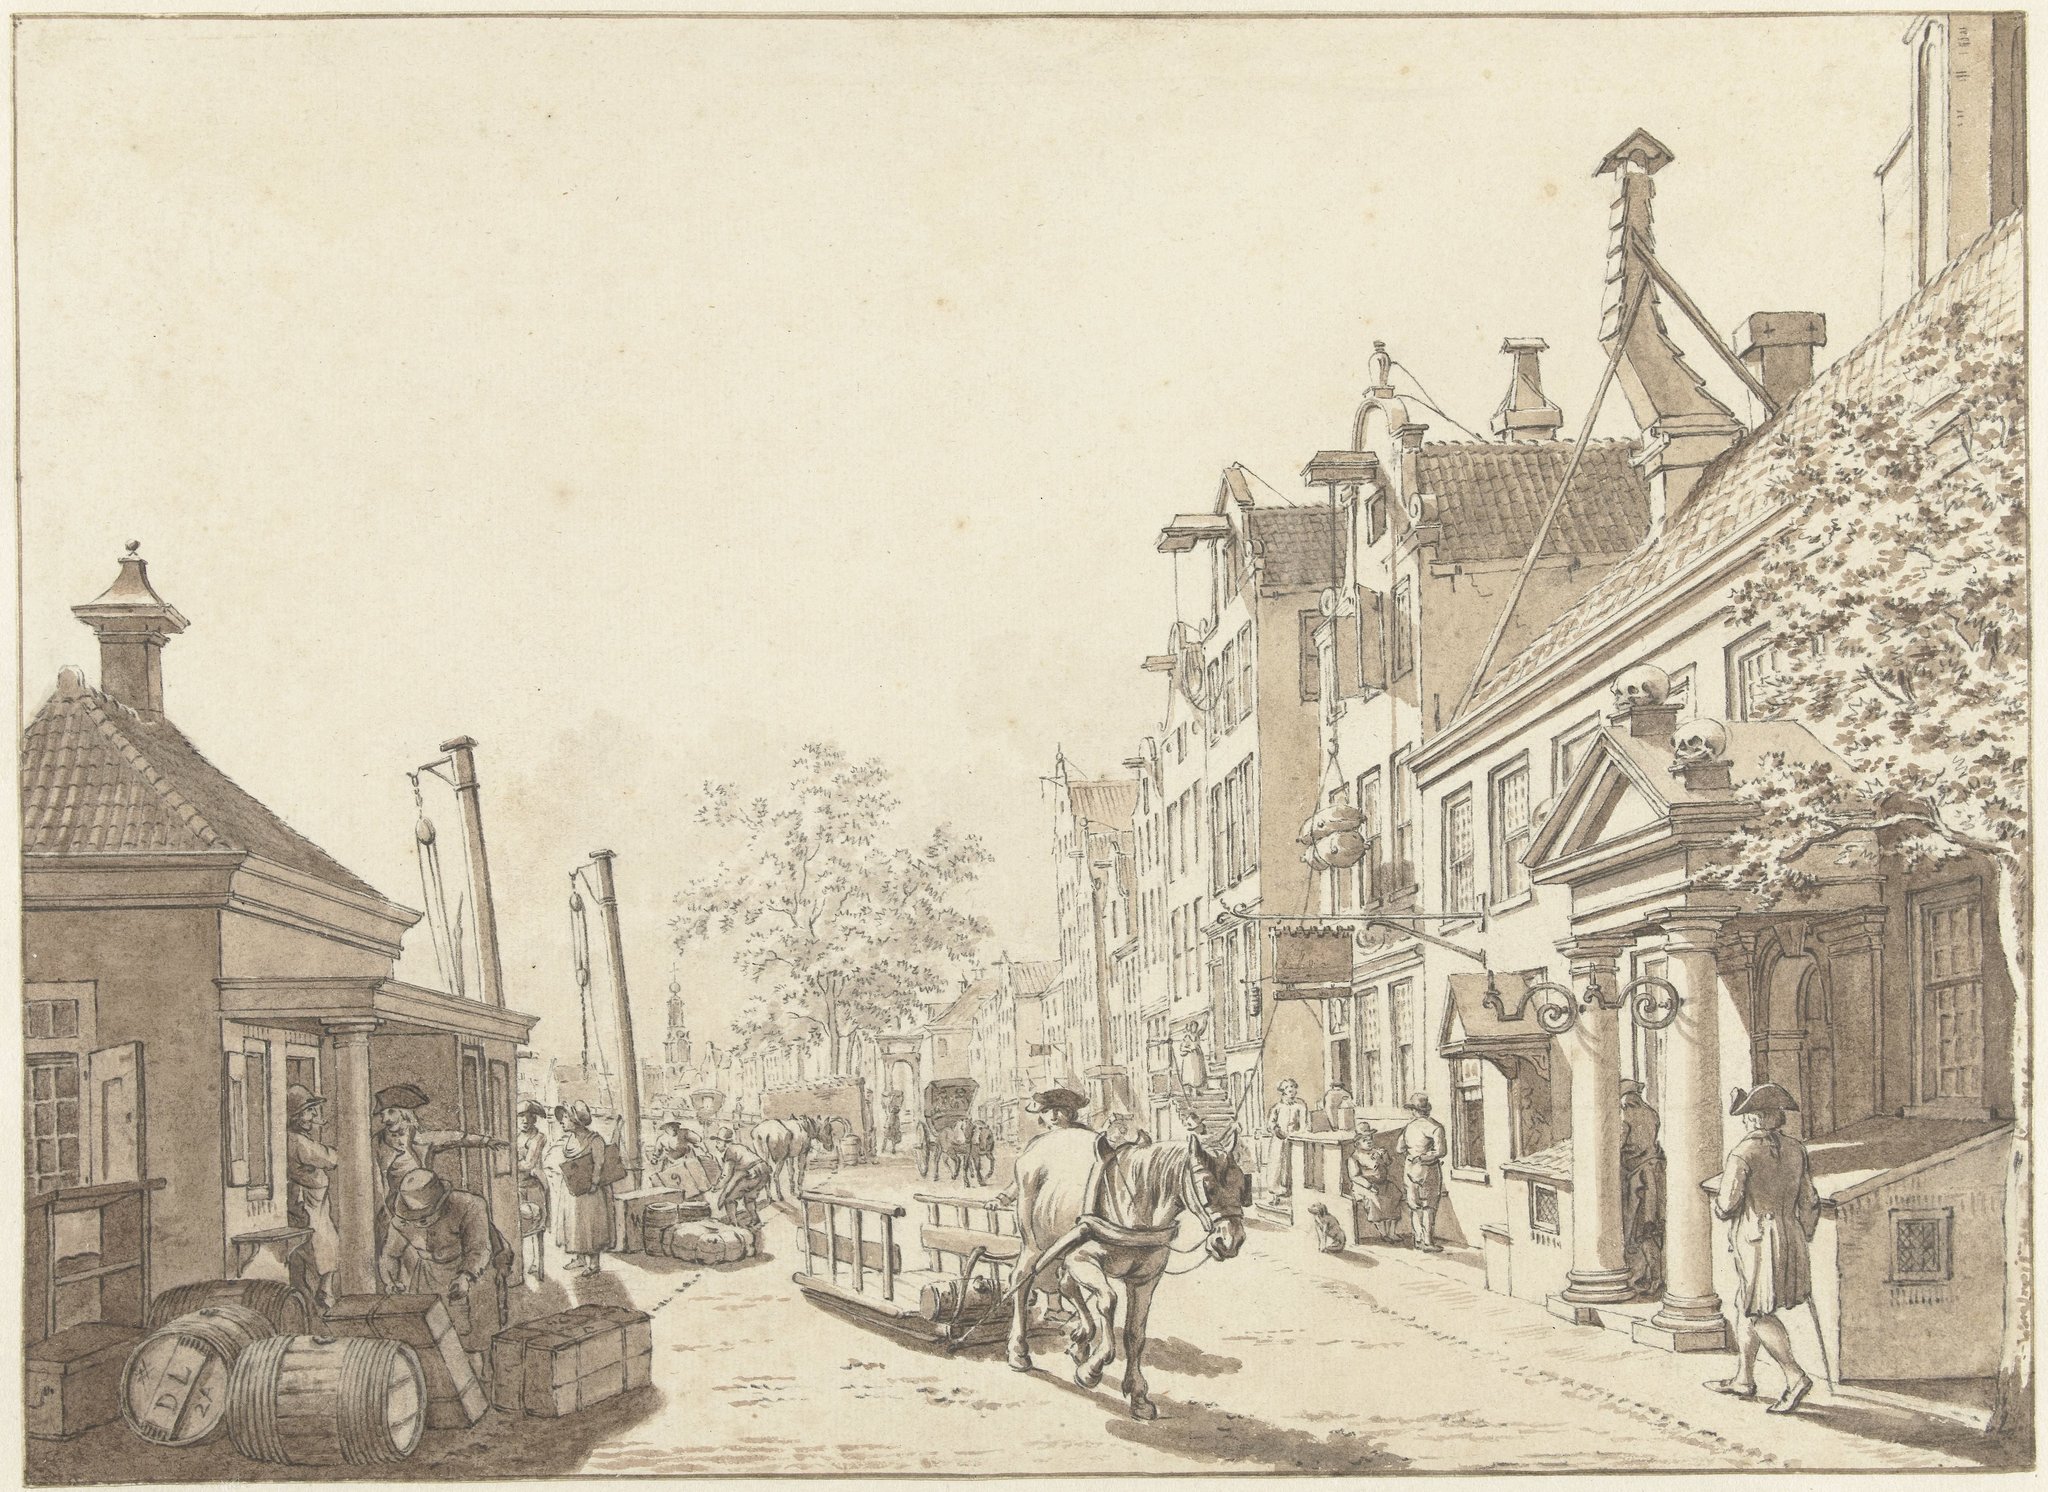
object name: drawing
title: Het Rokin, gezien naar de Munt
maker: jacob cats (1741-1799)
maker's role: draughtsman, print maker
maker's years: 1741-1799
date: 1785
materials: chalk, paper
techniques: brush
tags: public road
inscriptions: inscription: ‘Gezigt op het Rokin naar het Haegsche-Rotterdamsche Veer a.d. Munt (?)’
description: Gezicht op het Rokin naar het Haagsche-Rotterdamse Veer aan de Munt.